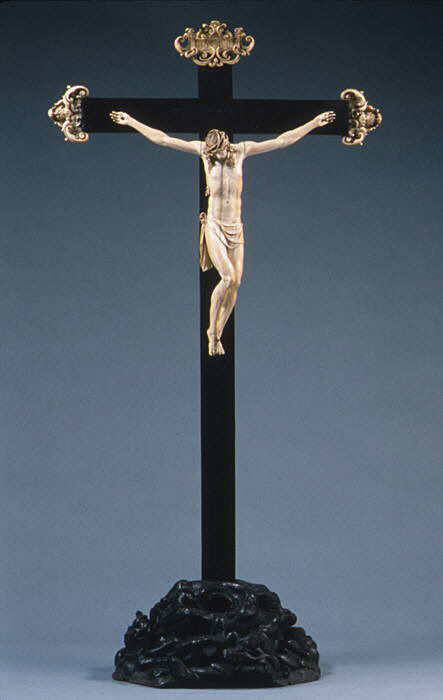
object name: crucifix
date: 1567-1633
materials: wood, ivory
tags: christ,cross,crucifixion